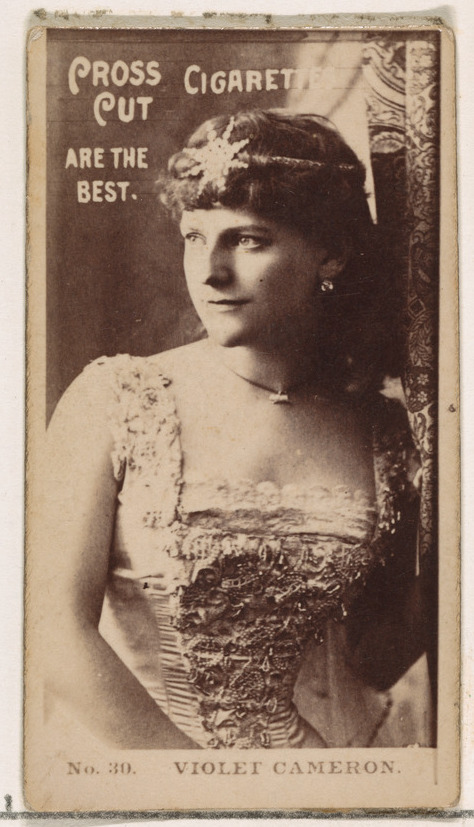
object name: print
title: Card Number 30, Violet Cameron, from the Actors and Actresses series (N145-2) issued by Duke Sons & Co. to promote Cross Cut Cigarettes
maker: w. duke, sons & co.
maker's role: publisher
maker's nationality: american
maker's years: 1870-1920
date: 1880-1889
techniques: albumen silver print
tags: portraits,women,actresses